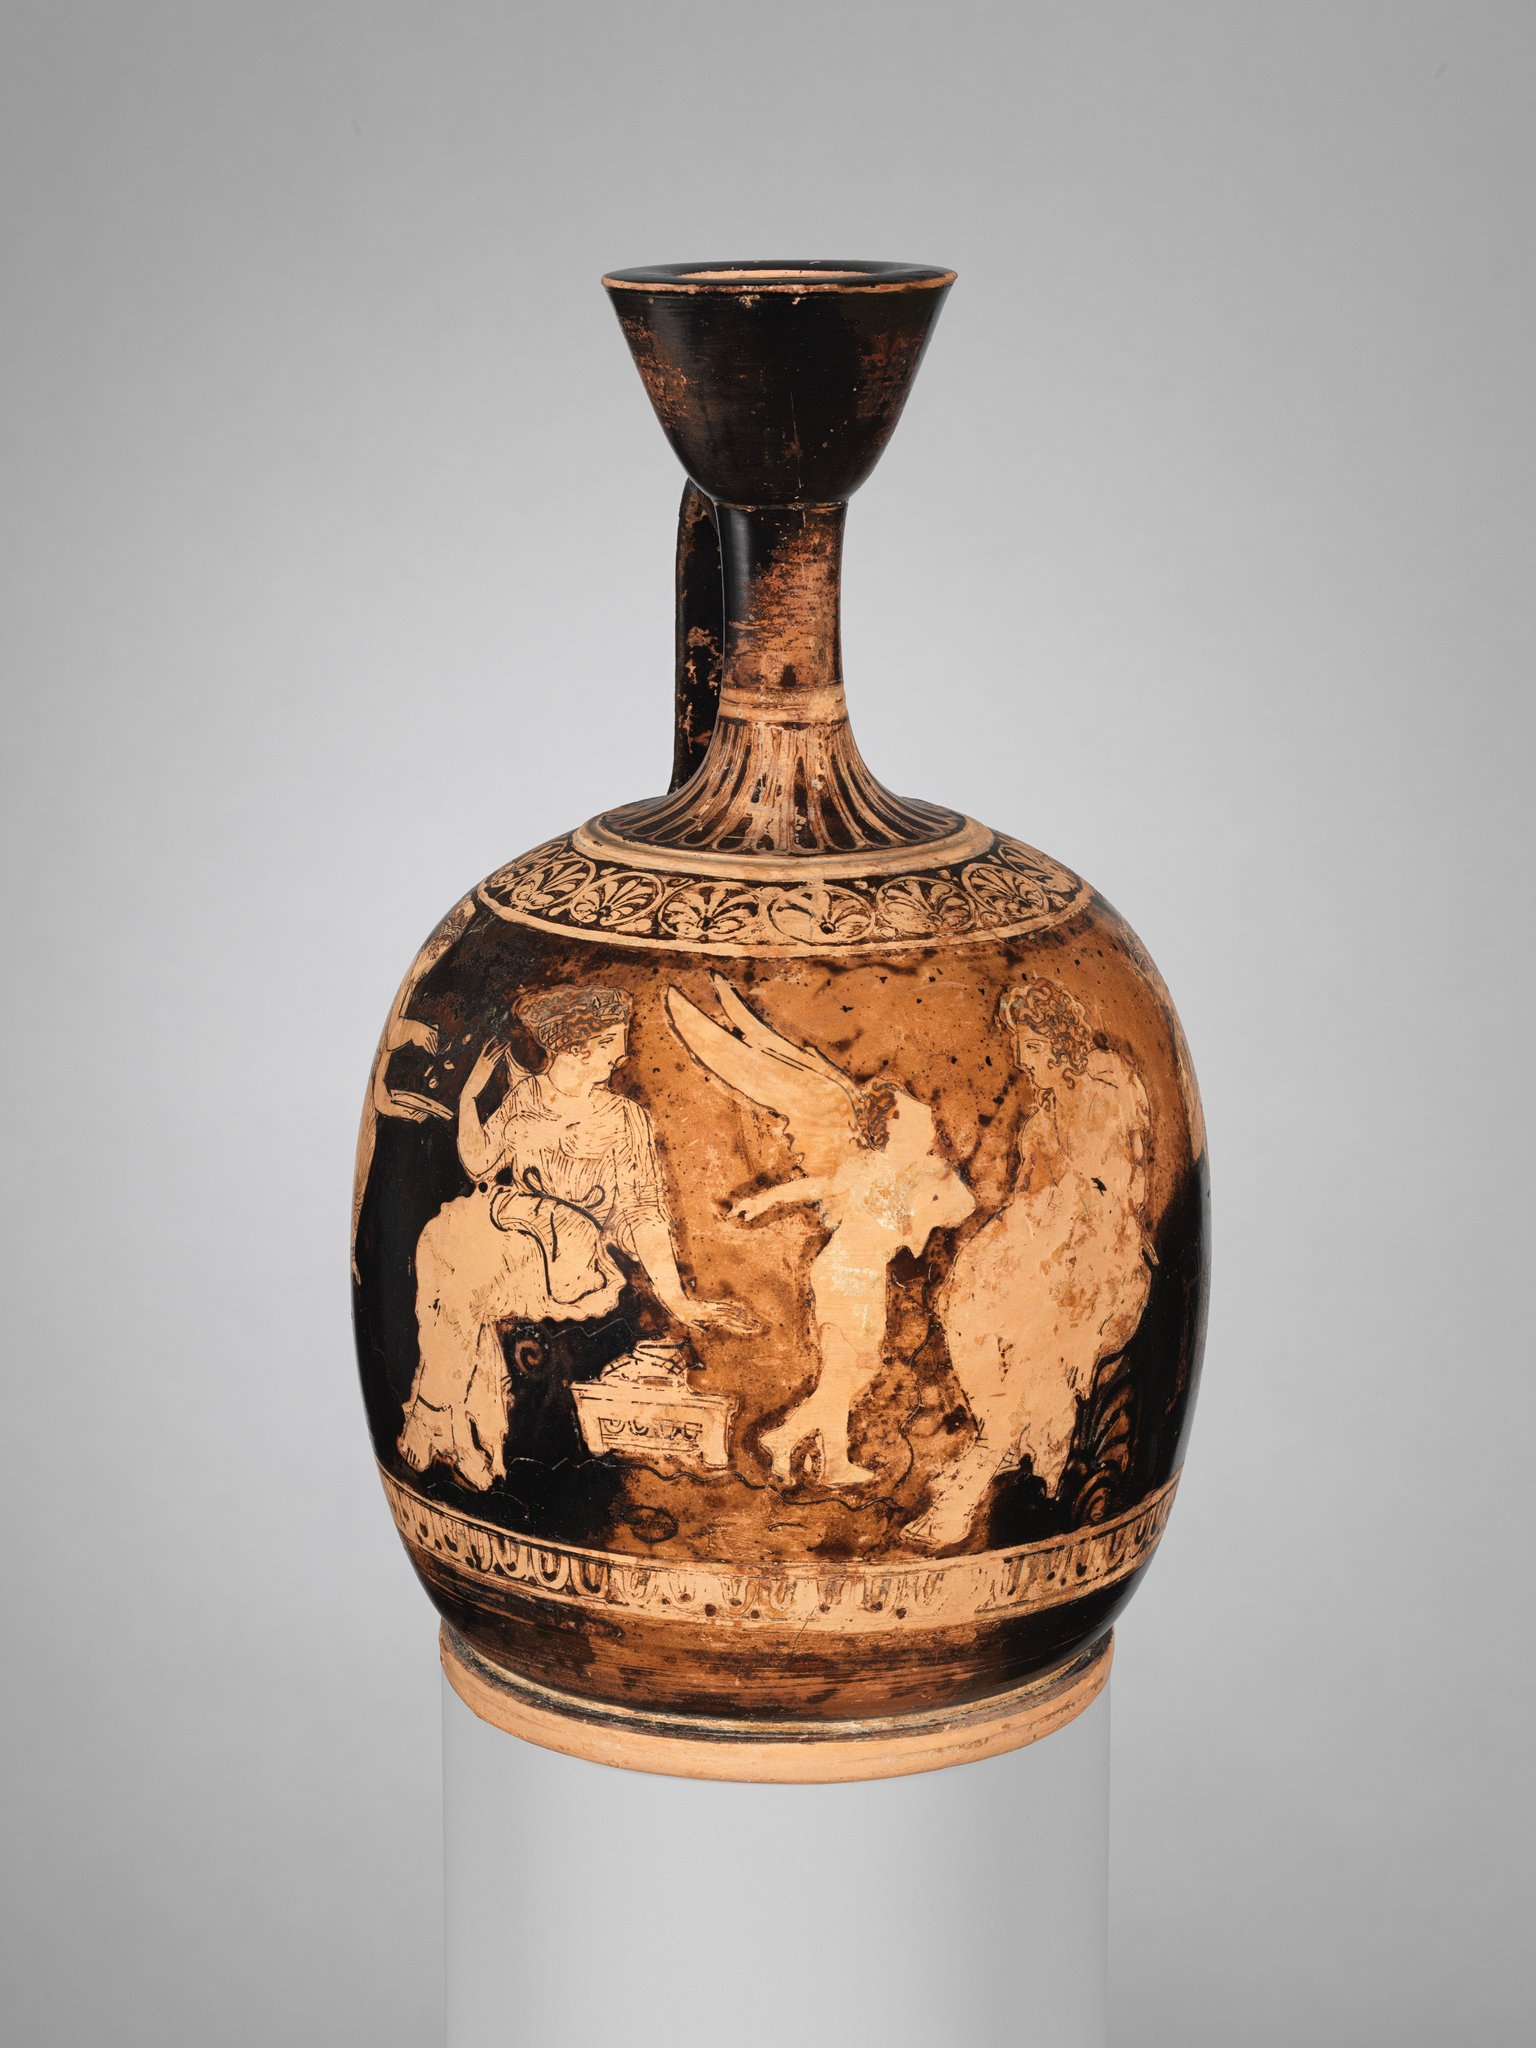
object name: squat lekythos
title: Terracotta squat lekythos (oil flask)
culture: greek, attic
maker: meidias painter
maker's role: artist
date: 410 BCE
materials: terracotta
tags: women,aphrodite,eros